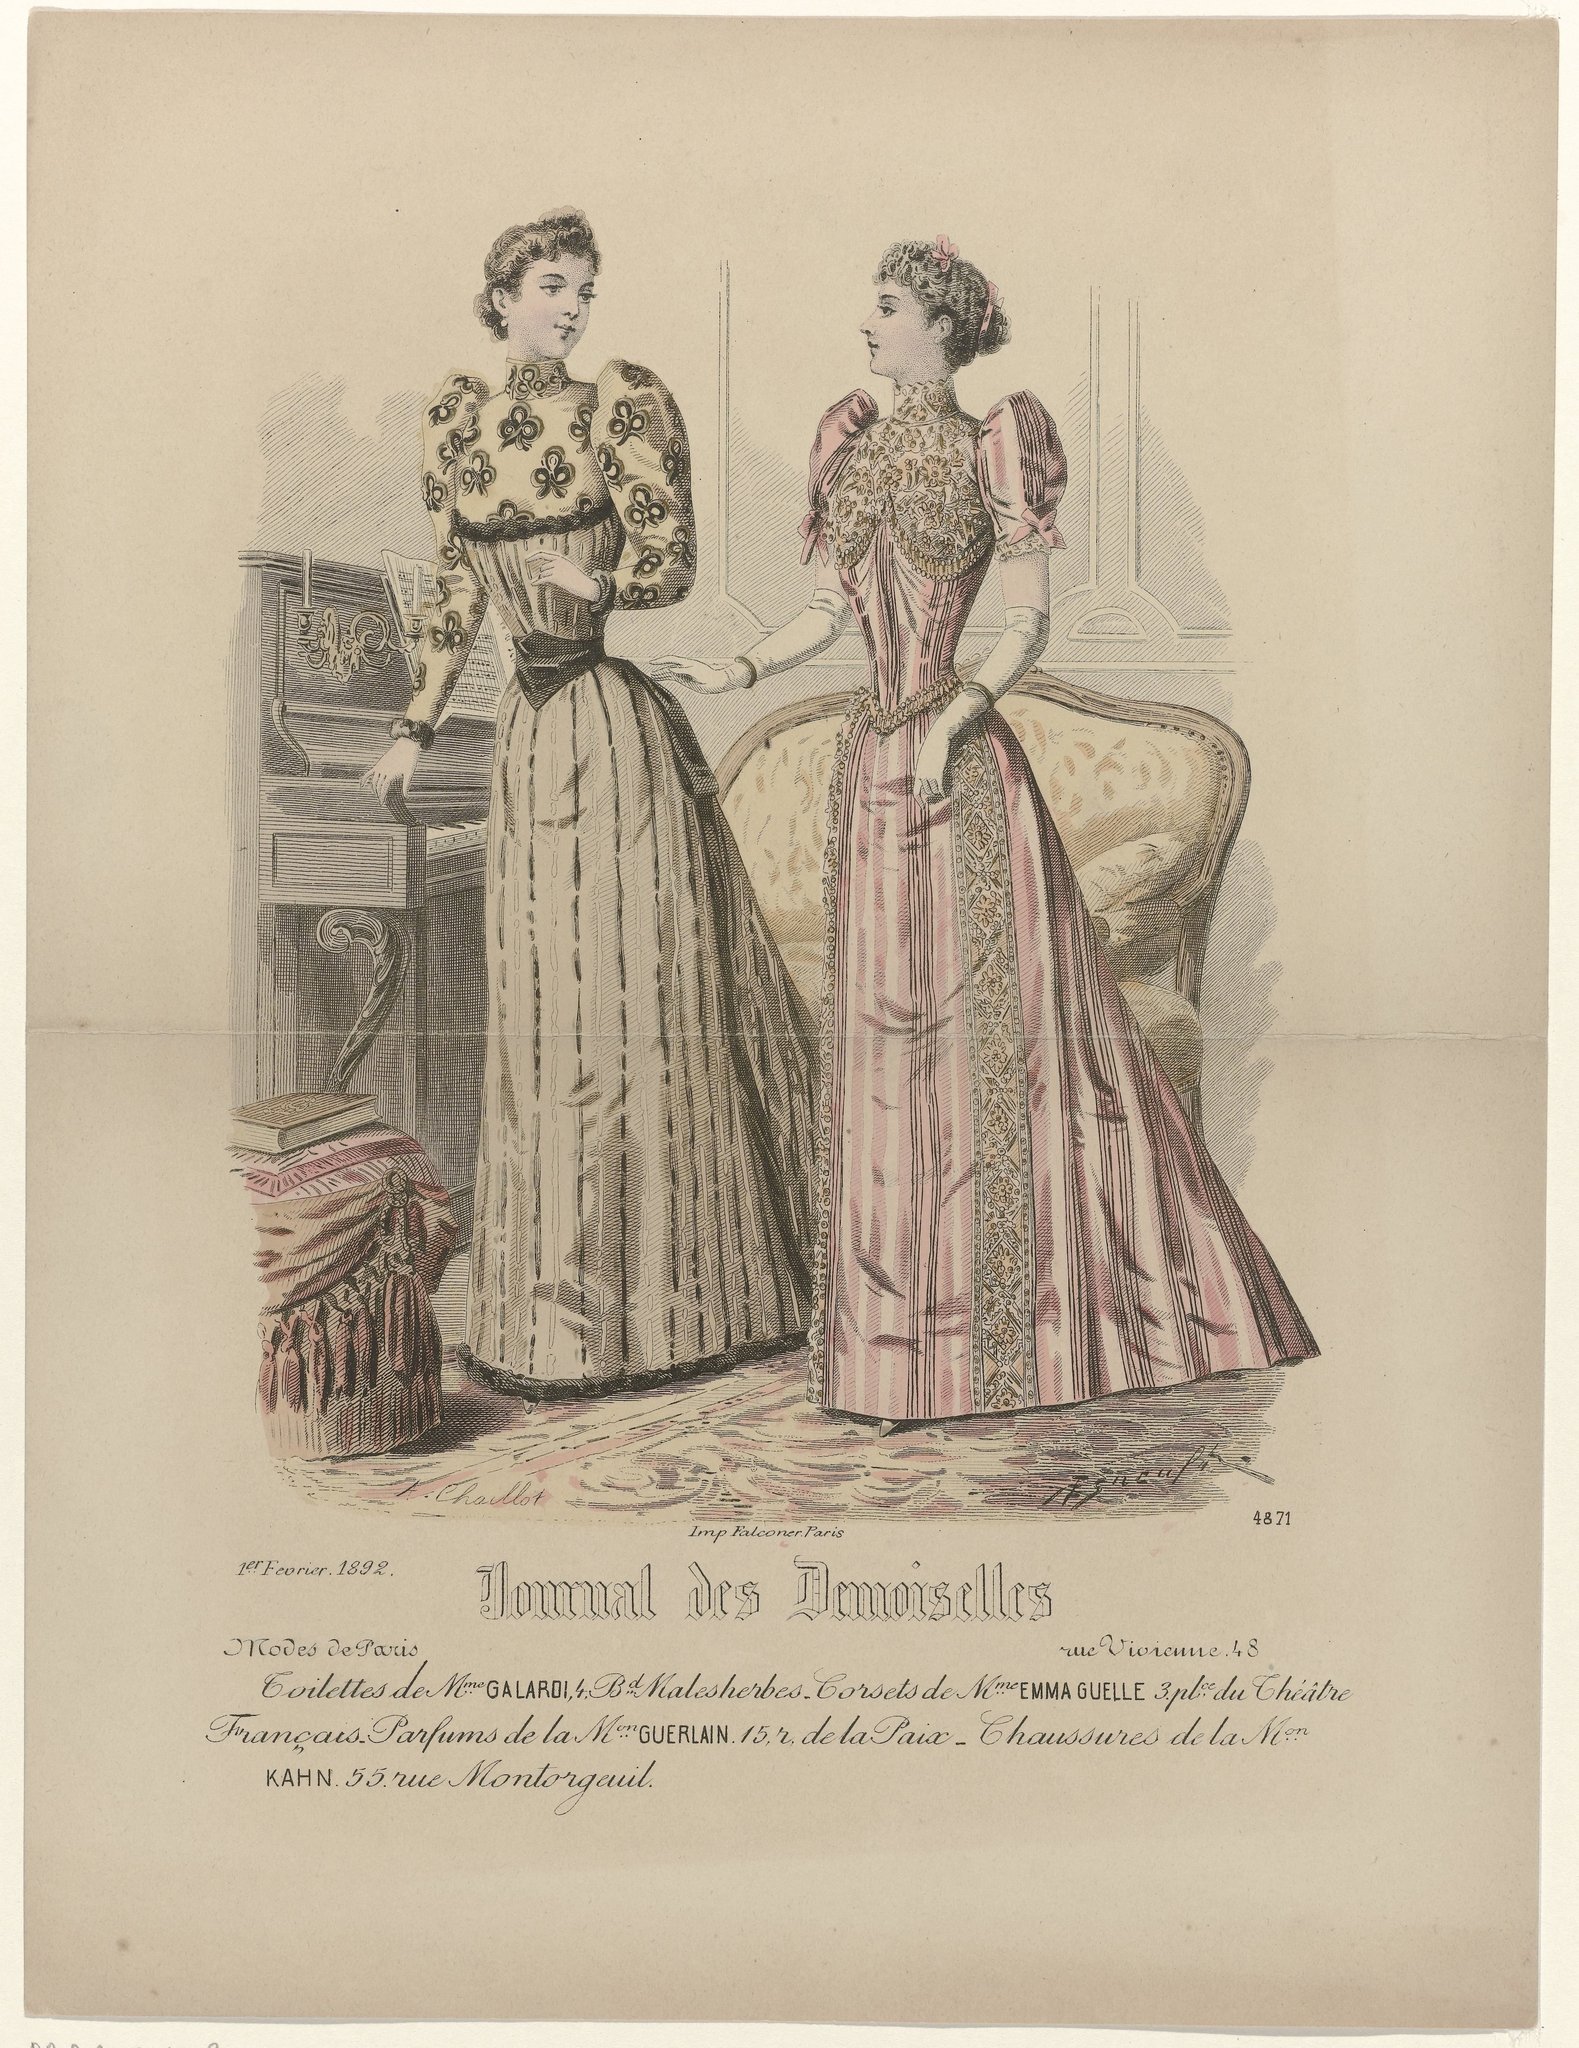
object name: fashion print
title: Journal des Demoiselles,1 fevrier 1892, No. 4871 : Toilettes de Mme Galard (...)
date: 1892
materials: paper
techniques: engraving, hand coloring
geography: paris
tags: fashion plates, gloves, mittens, etc. (+ women's clothes), dress, gown (+ women's clothes), bracelet, wristlet (+ women's clothes), pianoforte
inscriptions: title: ‘Journal des Demoiselles’, caption: ‘Toilettes de M.me Galardi, 4, B.d Malesherbes, Corsets de M.me Emma Guelle 3. pl.de du Théâtre Français. Parfums de la M.on Guerlain, 15, r, de la Paix _ Chaussures de la M.on Kahn, 55, rue Montorgeuil.’, address: ‘Modes de Paris / Rue Vivienne. 48’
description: Twee vrouwen bij een piano. Volgens het onderschrift: 'toilettes' van Galardi. Hieronder enkele regels reclametekst voor verschillende producten. Prent uit het modetijdschrift Journal des Demoiselles (1833 -1922).